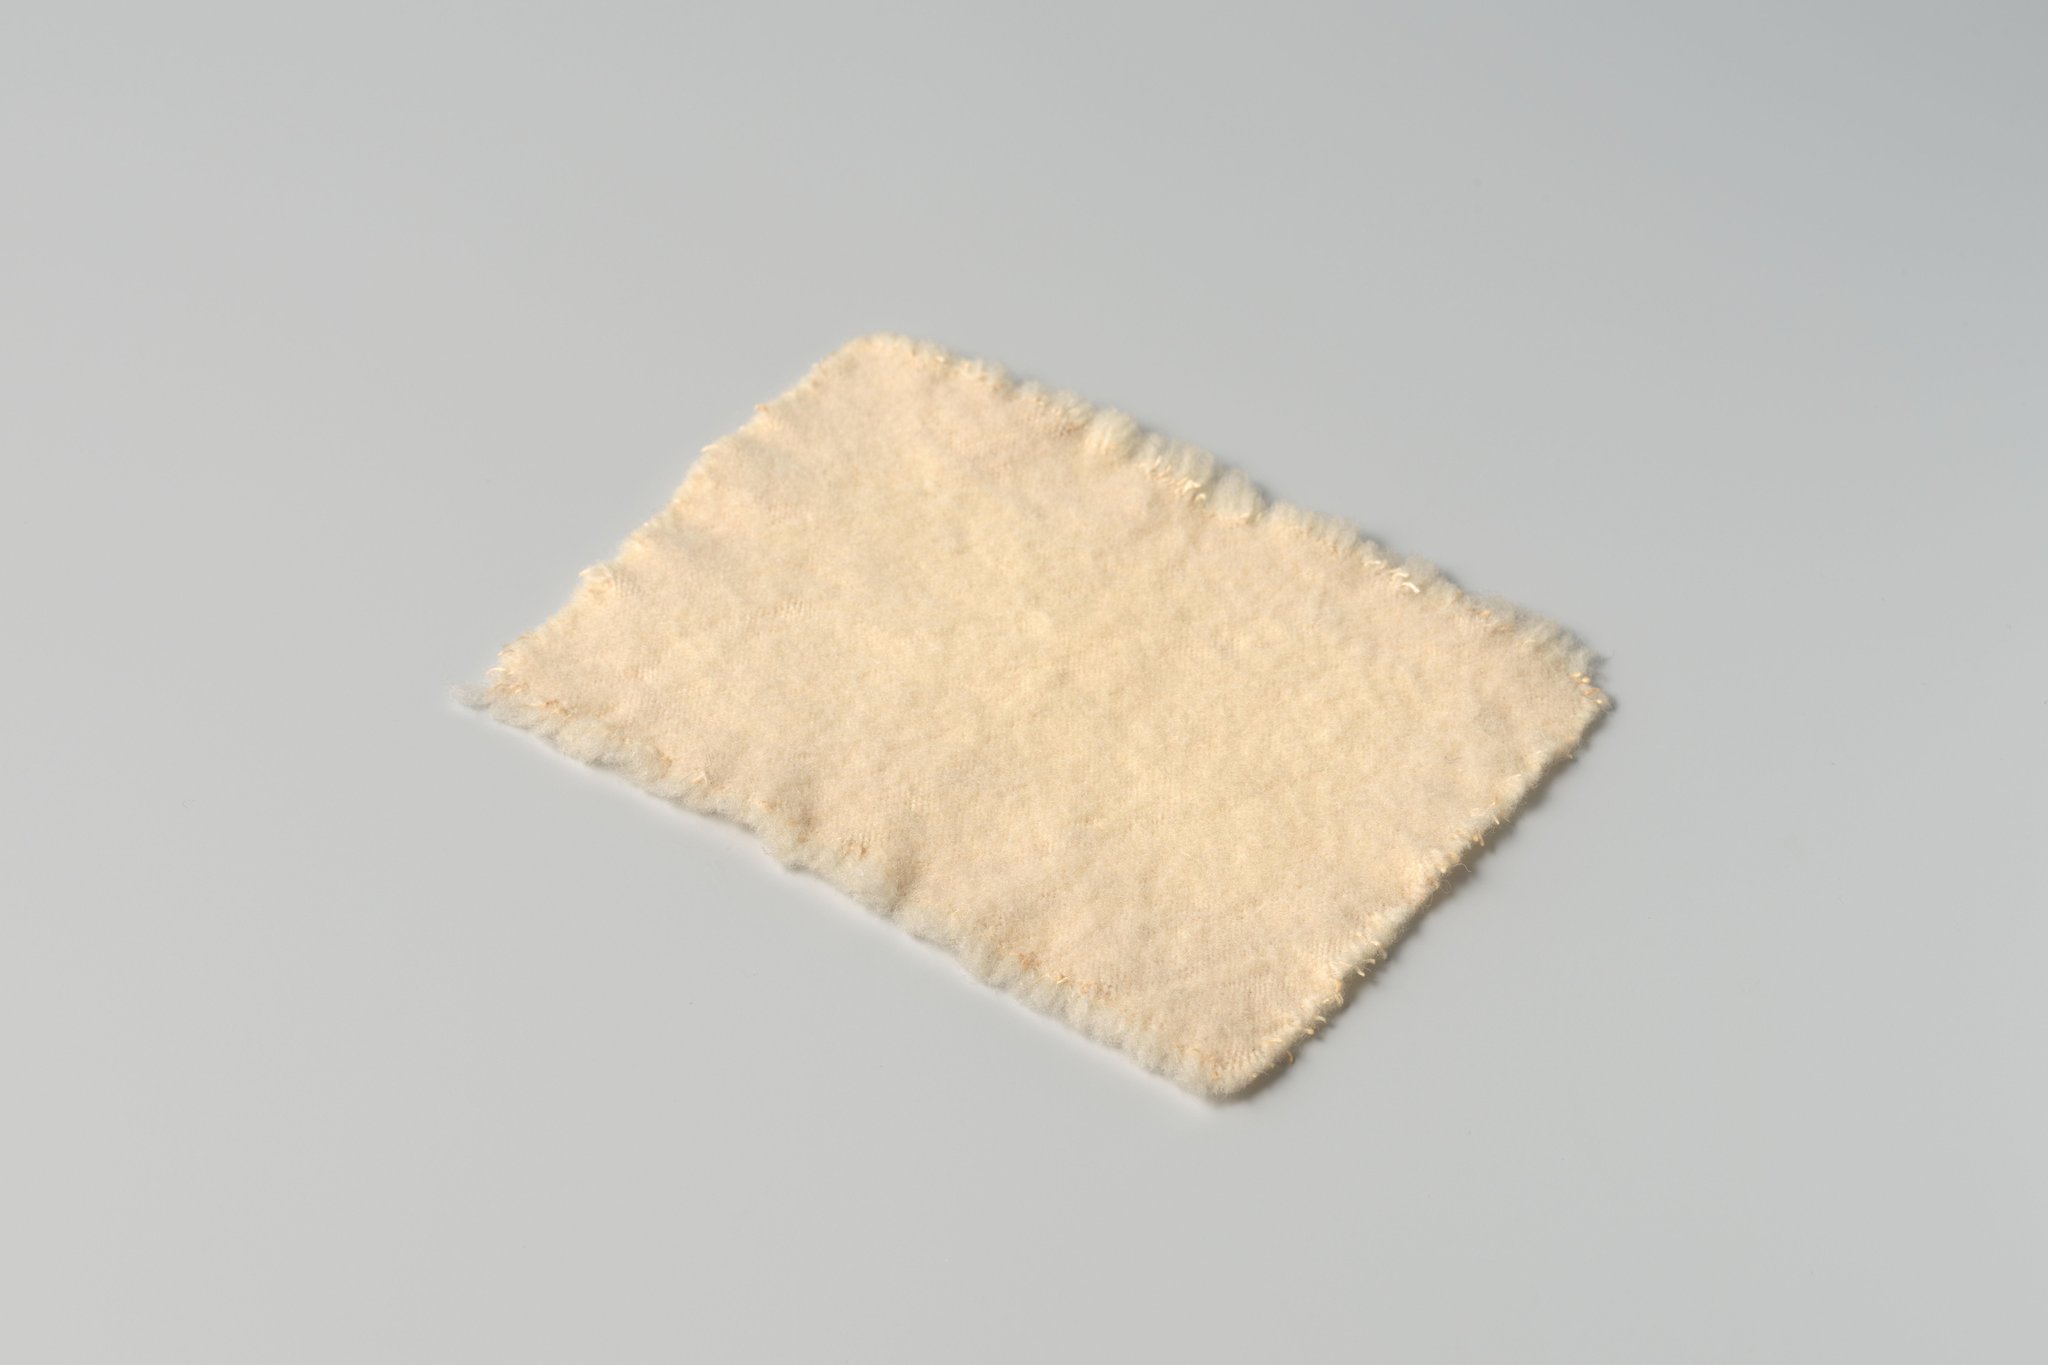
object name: strijkplankkleed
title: Strijkplankkleed van geruwde witte wol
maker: Anonymous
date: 1676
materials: linen, wool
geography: amsterdam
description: Strijkplankkleed van geruwde witte wol (inslag) en linnen (ketting), schuin op de draad geknipt.